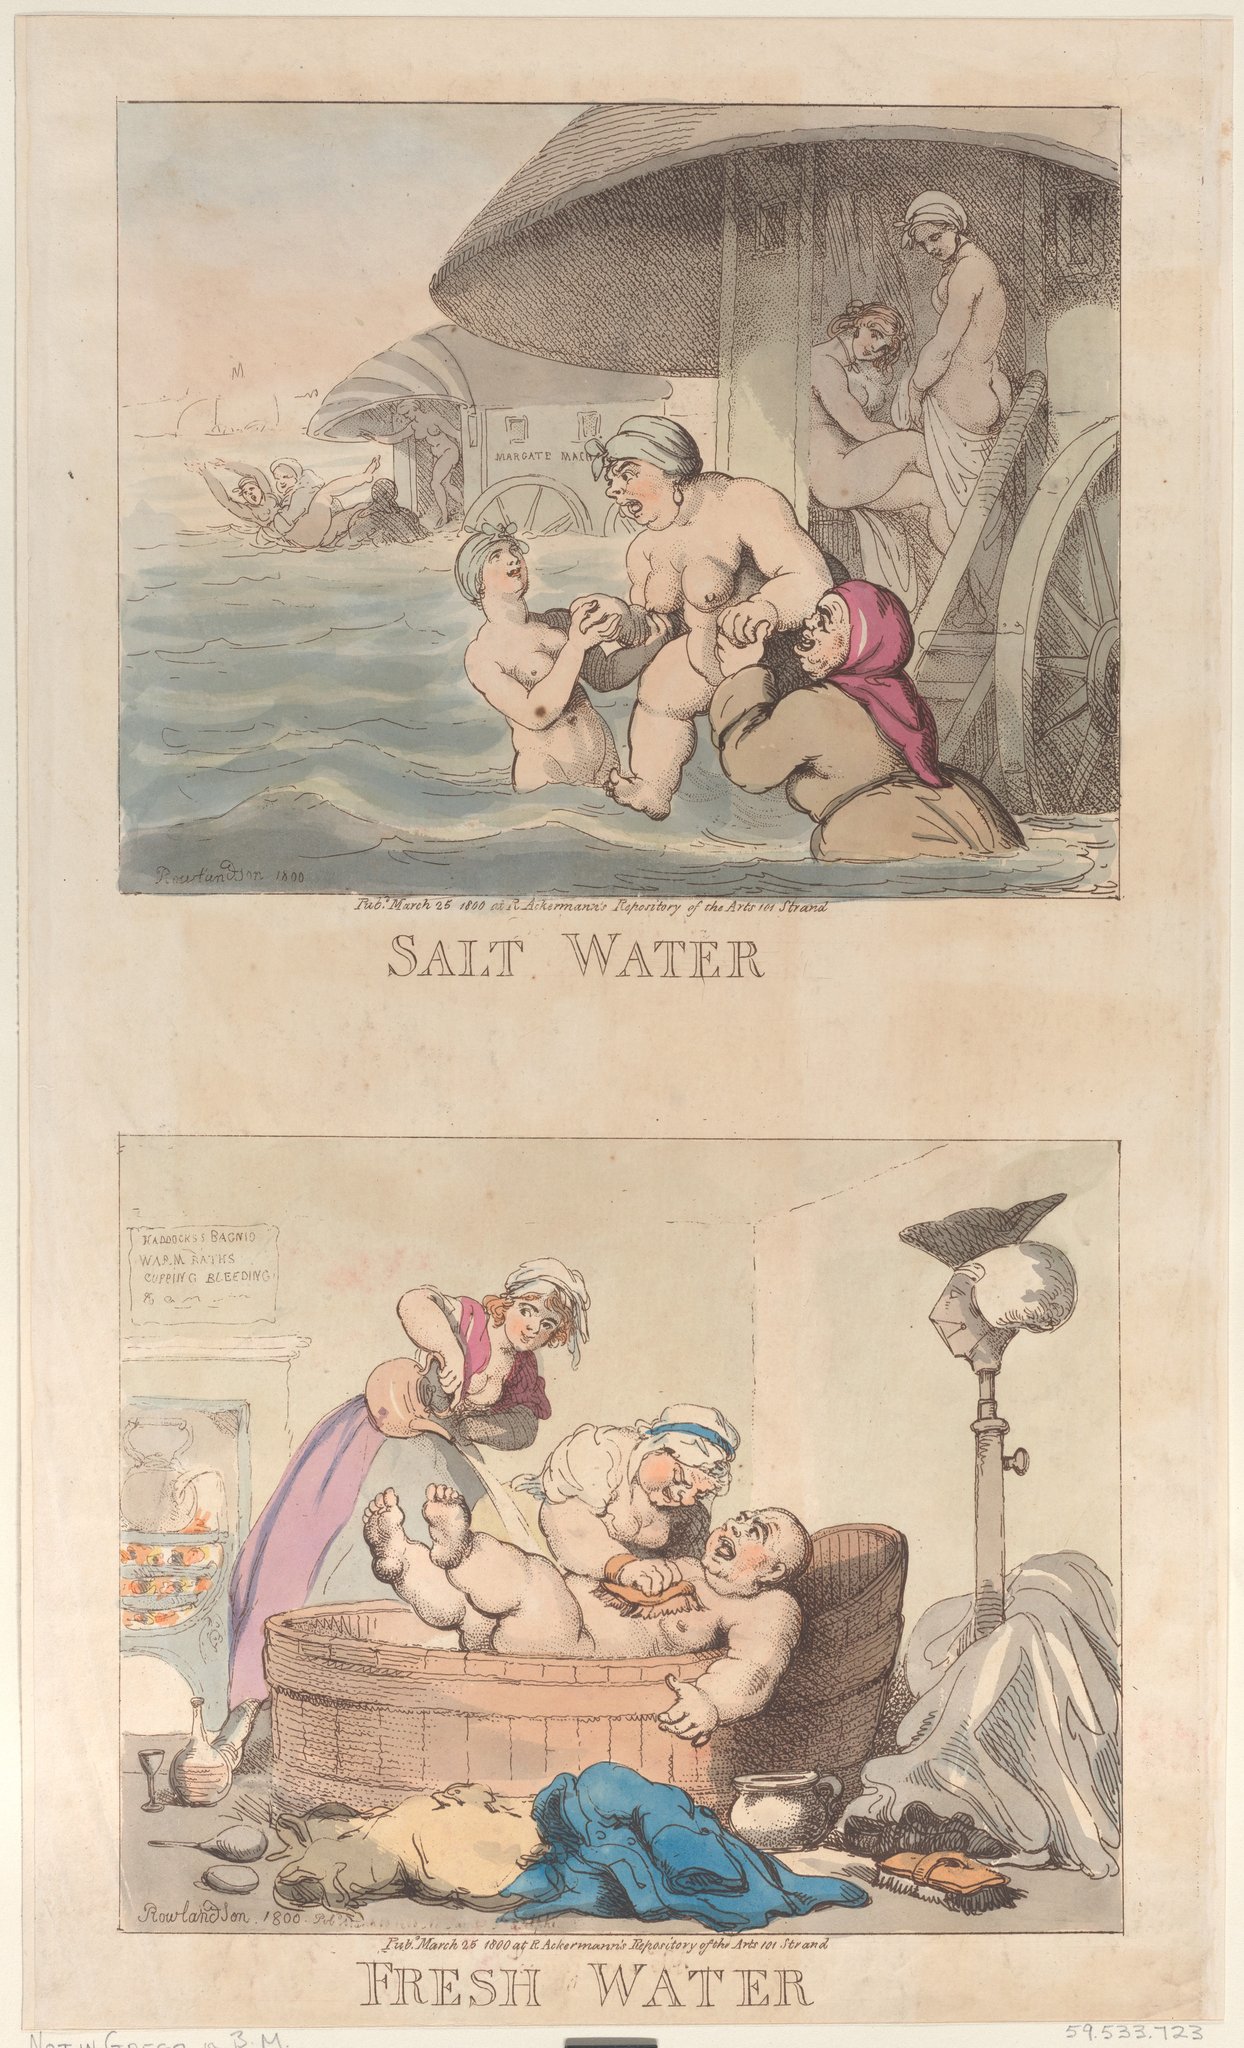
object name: print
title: Salt Water and Fresh Water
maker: thomas rowlandson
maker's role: artist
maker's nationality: british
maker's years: 1757-1827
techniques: aquatint, etching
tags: satire,men,women,female nudes,bathing